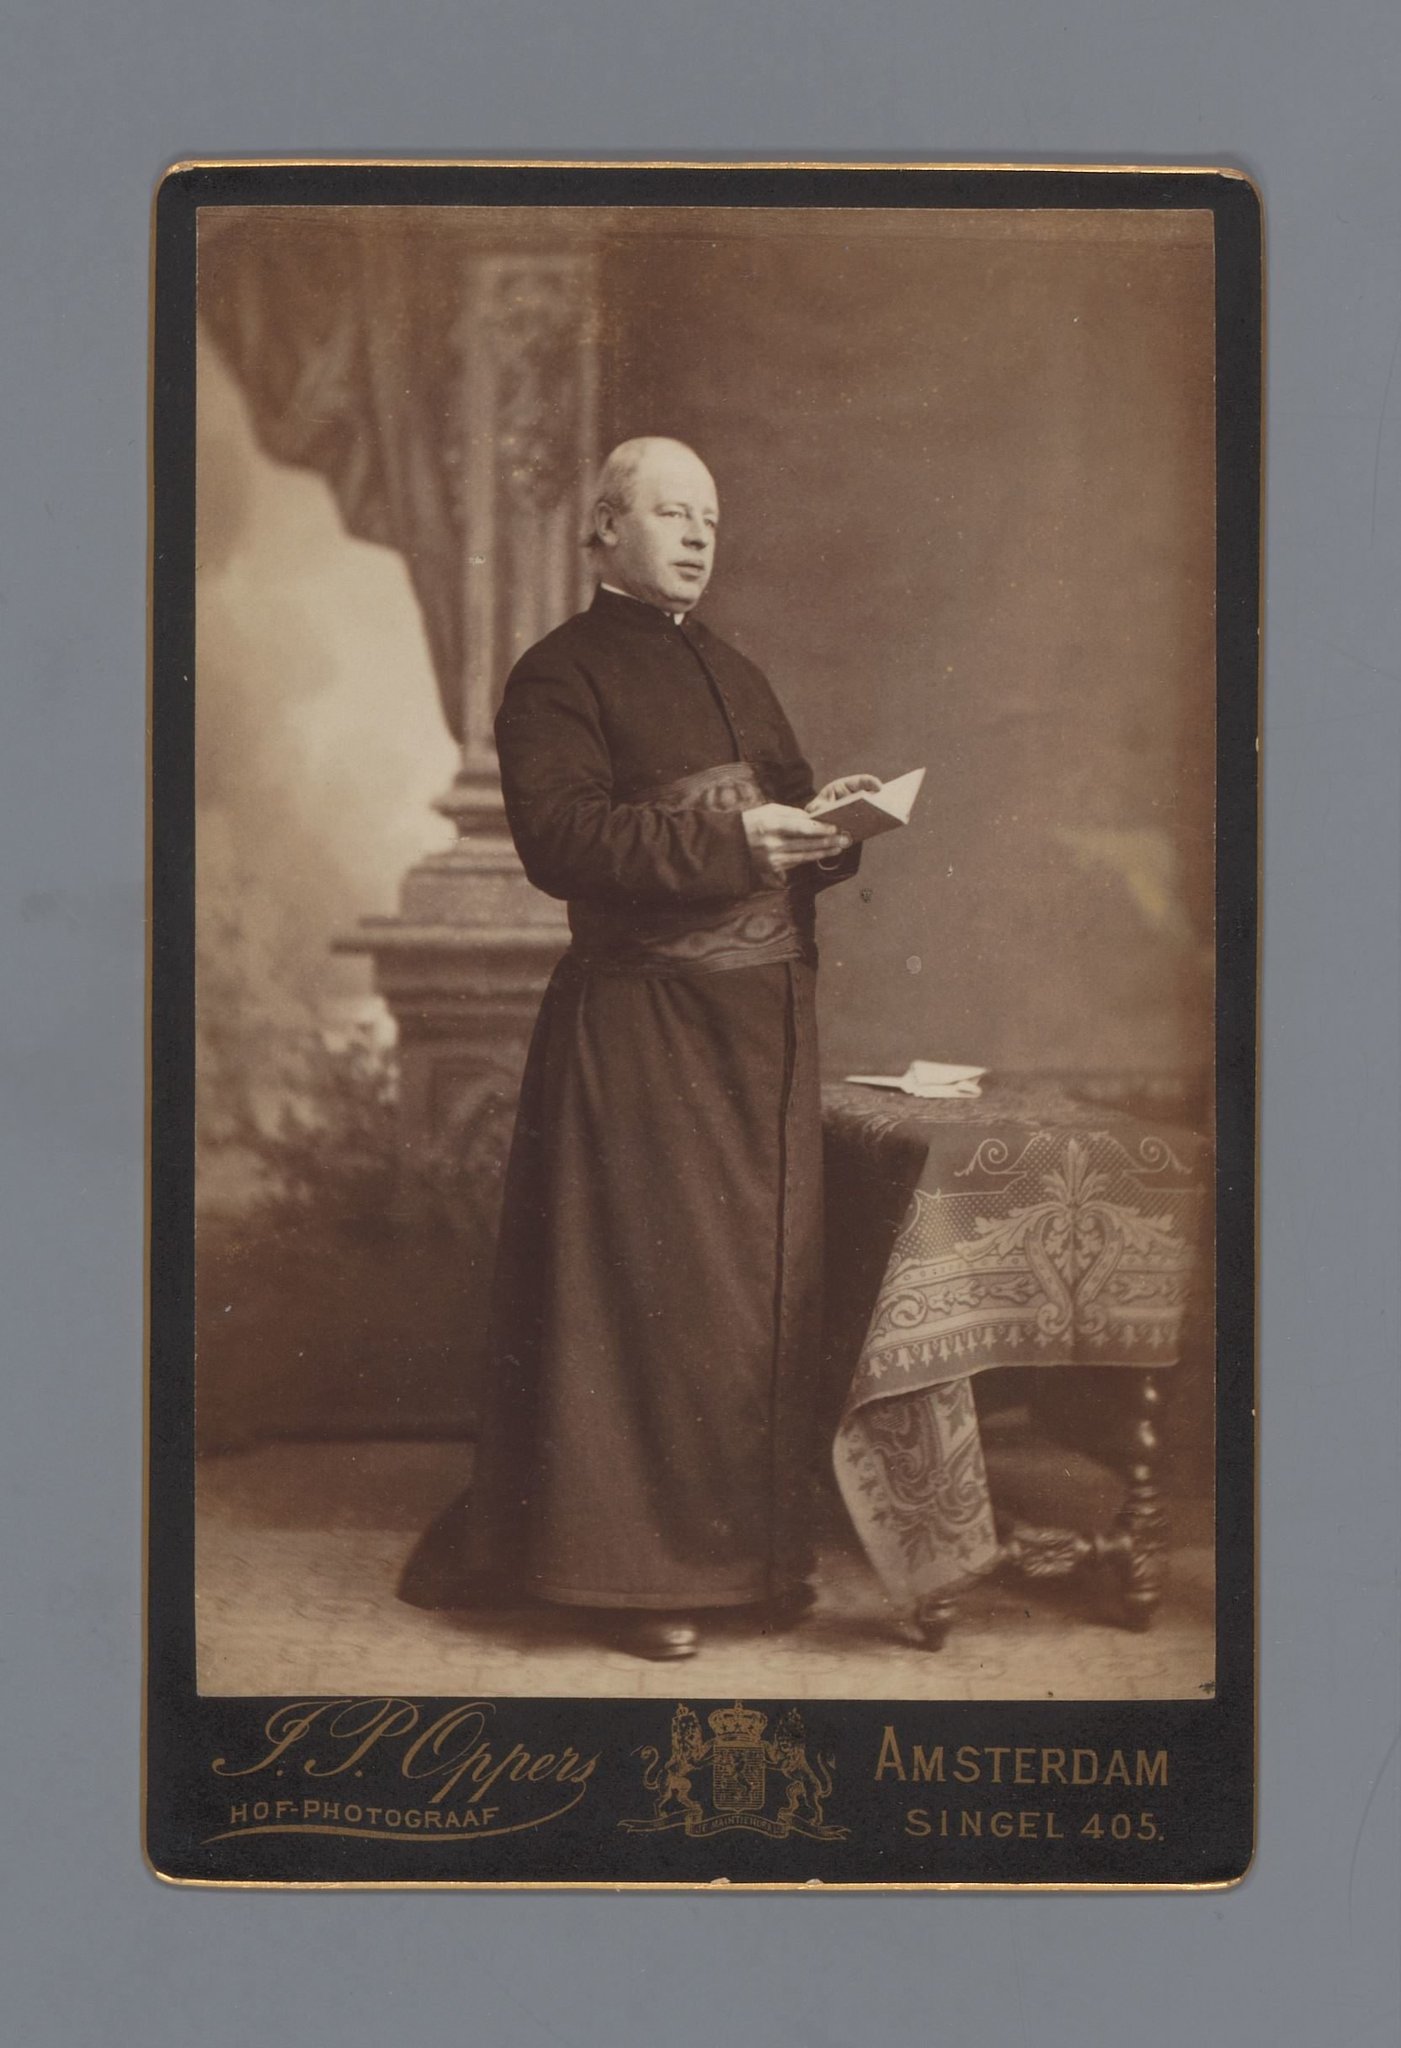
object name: cabinet photograph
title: Studioportret van een geestelijke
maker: johannes petrus oppers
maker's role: fotograaf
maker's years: 1833-1890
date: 1875-1900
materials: cardboard, photographic support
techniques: albumen print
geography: amsterdam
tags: organization, functionaries and dignitaries in roman catholic church; clergy in general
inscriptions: name: ‘J. P. Oppers hof-photograaf Amsterdam Singel 405.’, inscription: ‘H. Sikkes opvolger van J. P. Oppers Singel 405, Amsterdam’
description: RP-F-F18955 is een ander exemplaar van dezelfde foto.